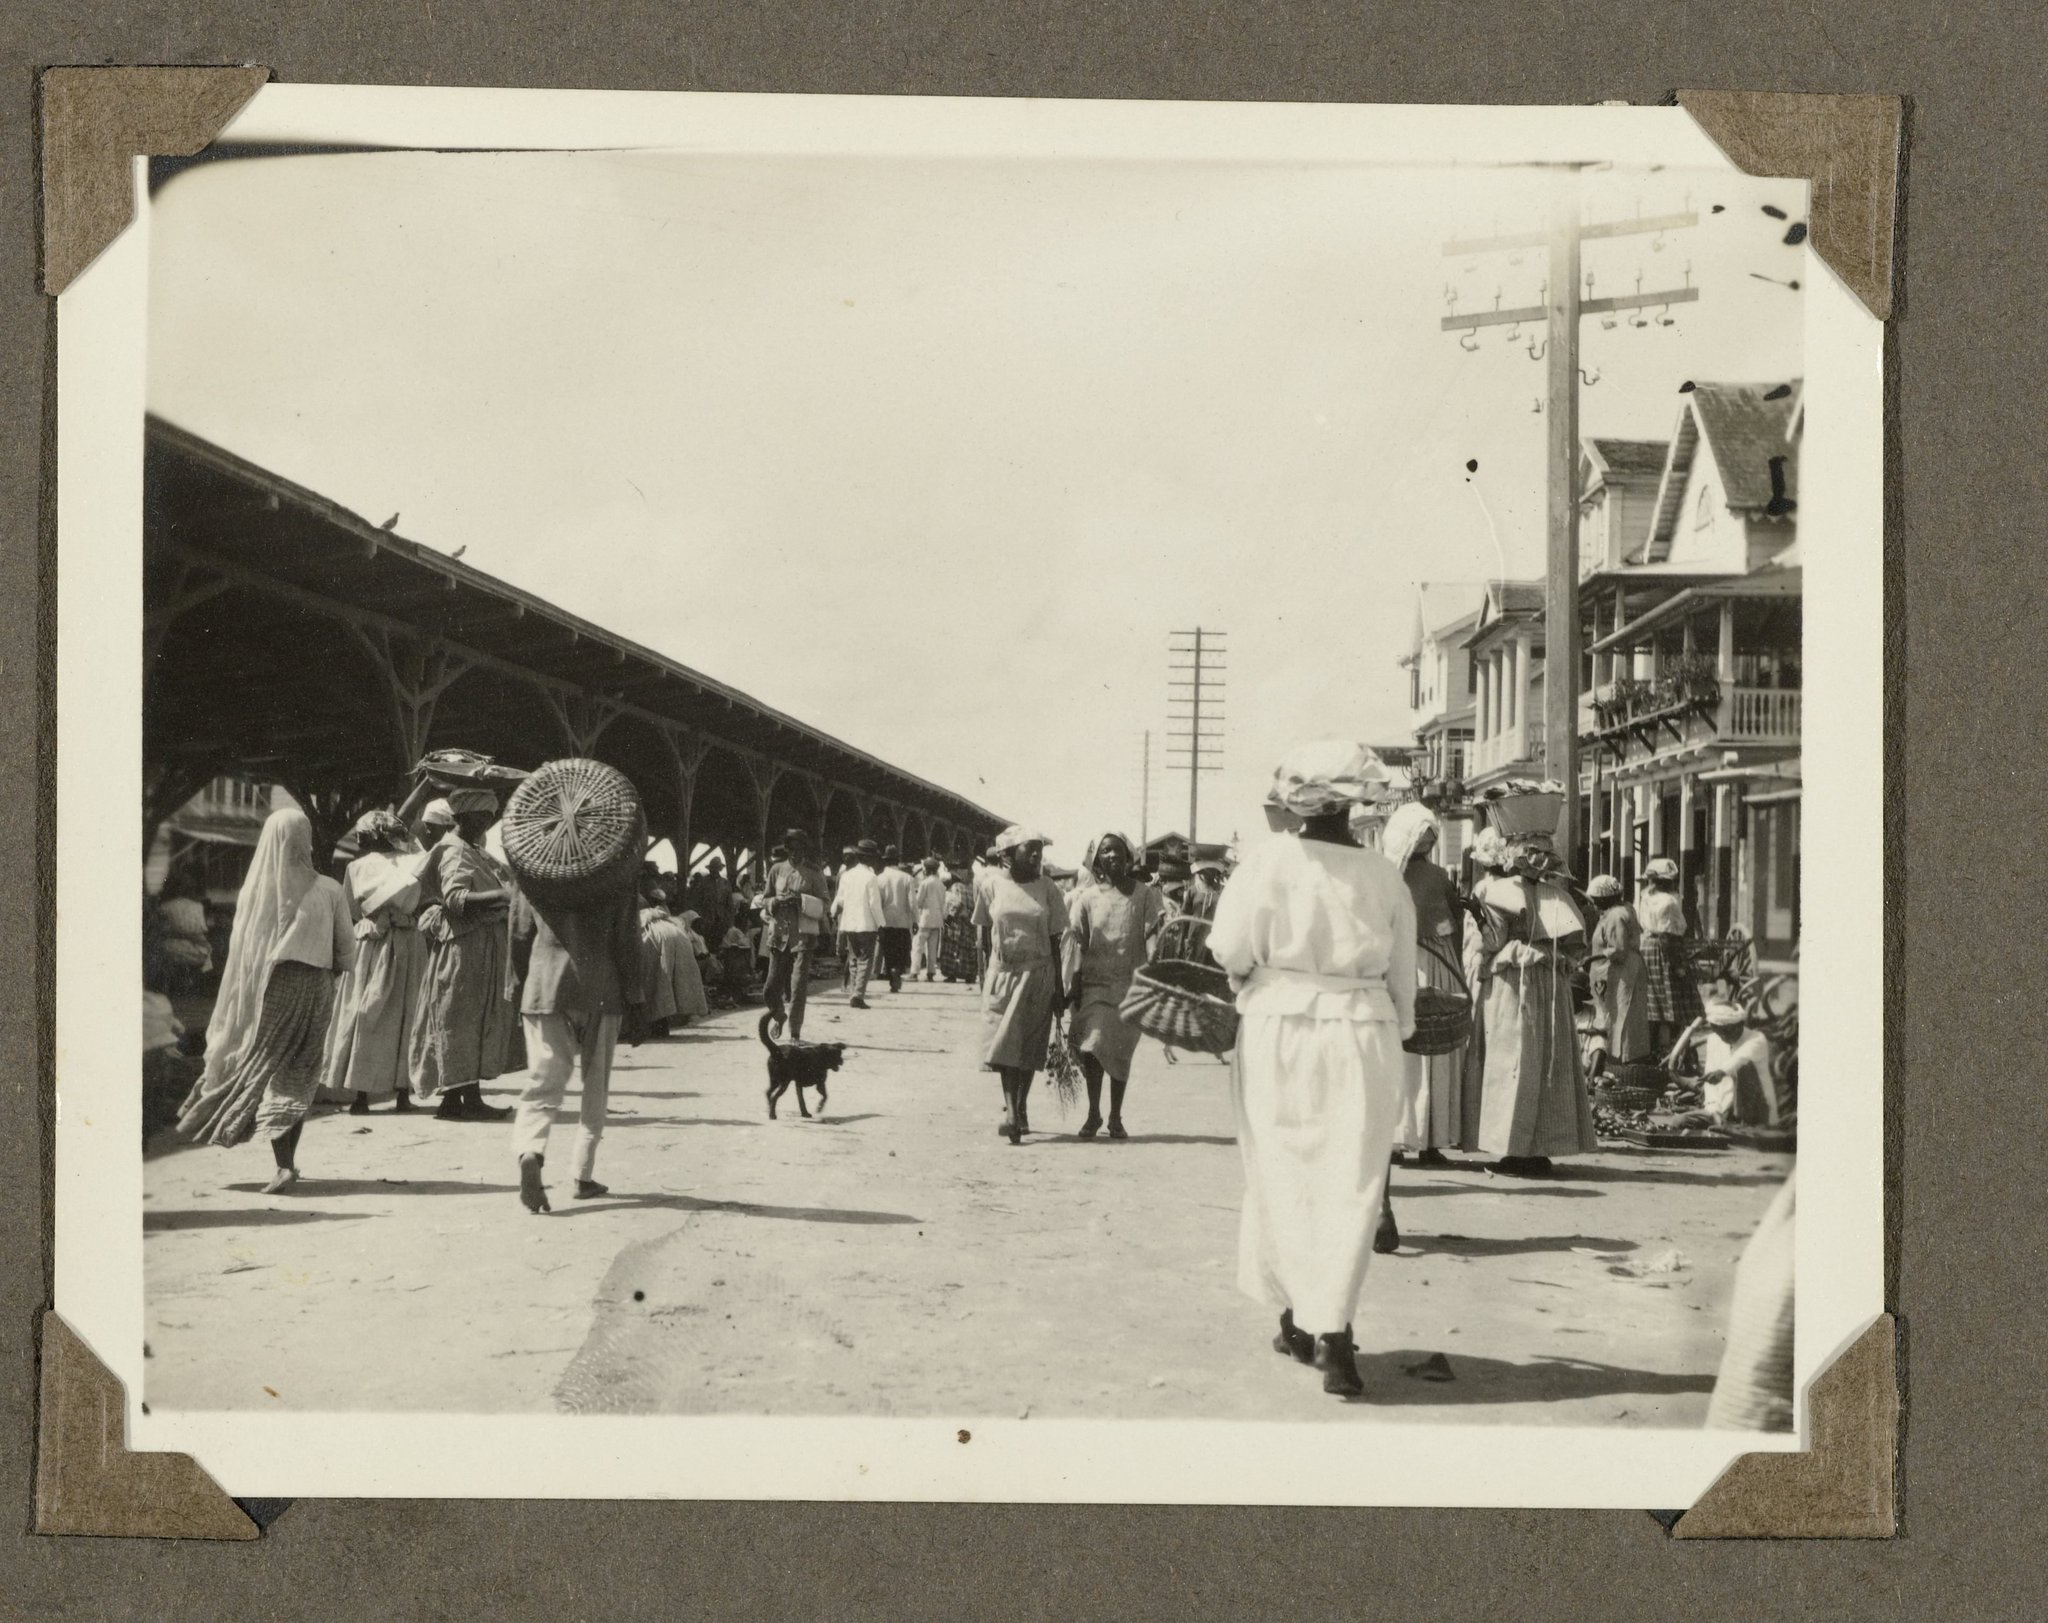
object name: photograph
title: Treinstation in Suriname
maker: Anonymous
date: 1925-1927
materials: photographic support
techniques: photography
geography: suriname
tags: station; shelter (railway, tramway), suriname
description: Treinstation in Suriname. Foto met hoekjes bevestigd op een bladzijde van een albumblad in het fotoalbum over de familie Jetten en het leven en werken in de mijnstad Moengo in Suriname rond 1927.